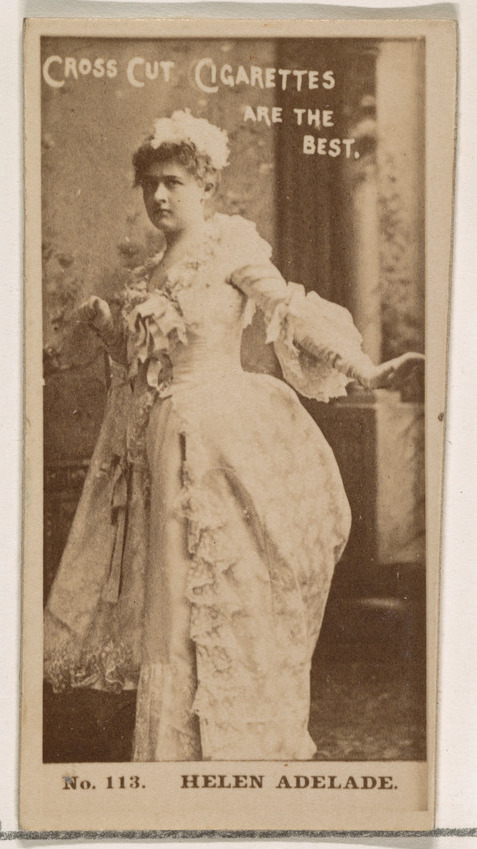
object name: print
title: Card Number 113, Helen Adelade, from the Actors and Actresses series (N145-2) issued by Duke Sons & Co. to promote Cross Cut Cigarettes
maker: w. duke, sons & co.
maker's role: publisher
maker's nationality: american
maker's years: 1870-1920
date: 1880-1889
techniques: albumen silver print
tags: portraits,women,actresses